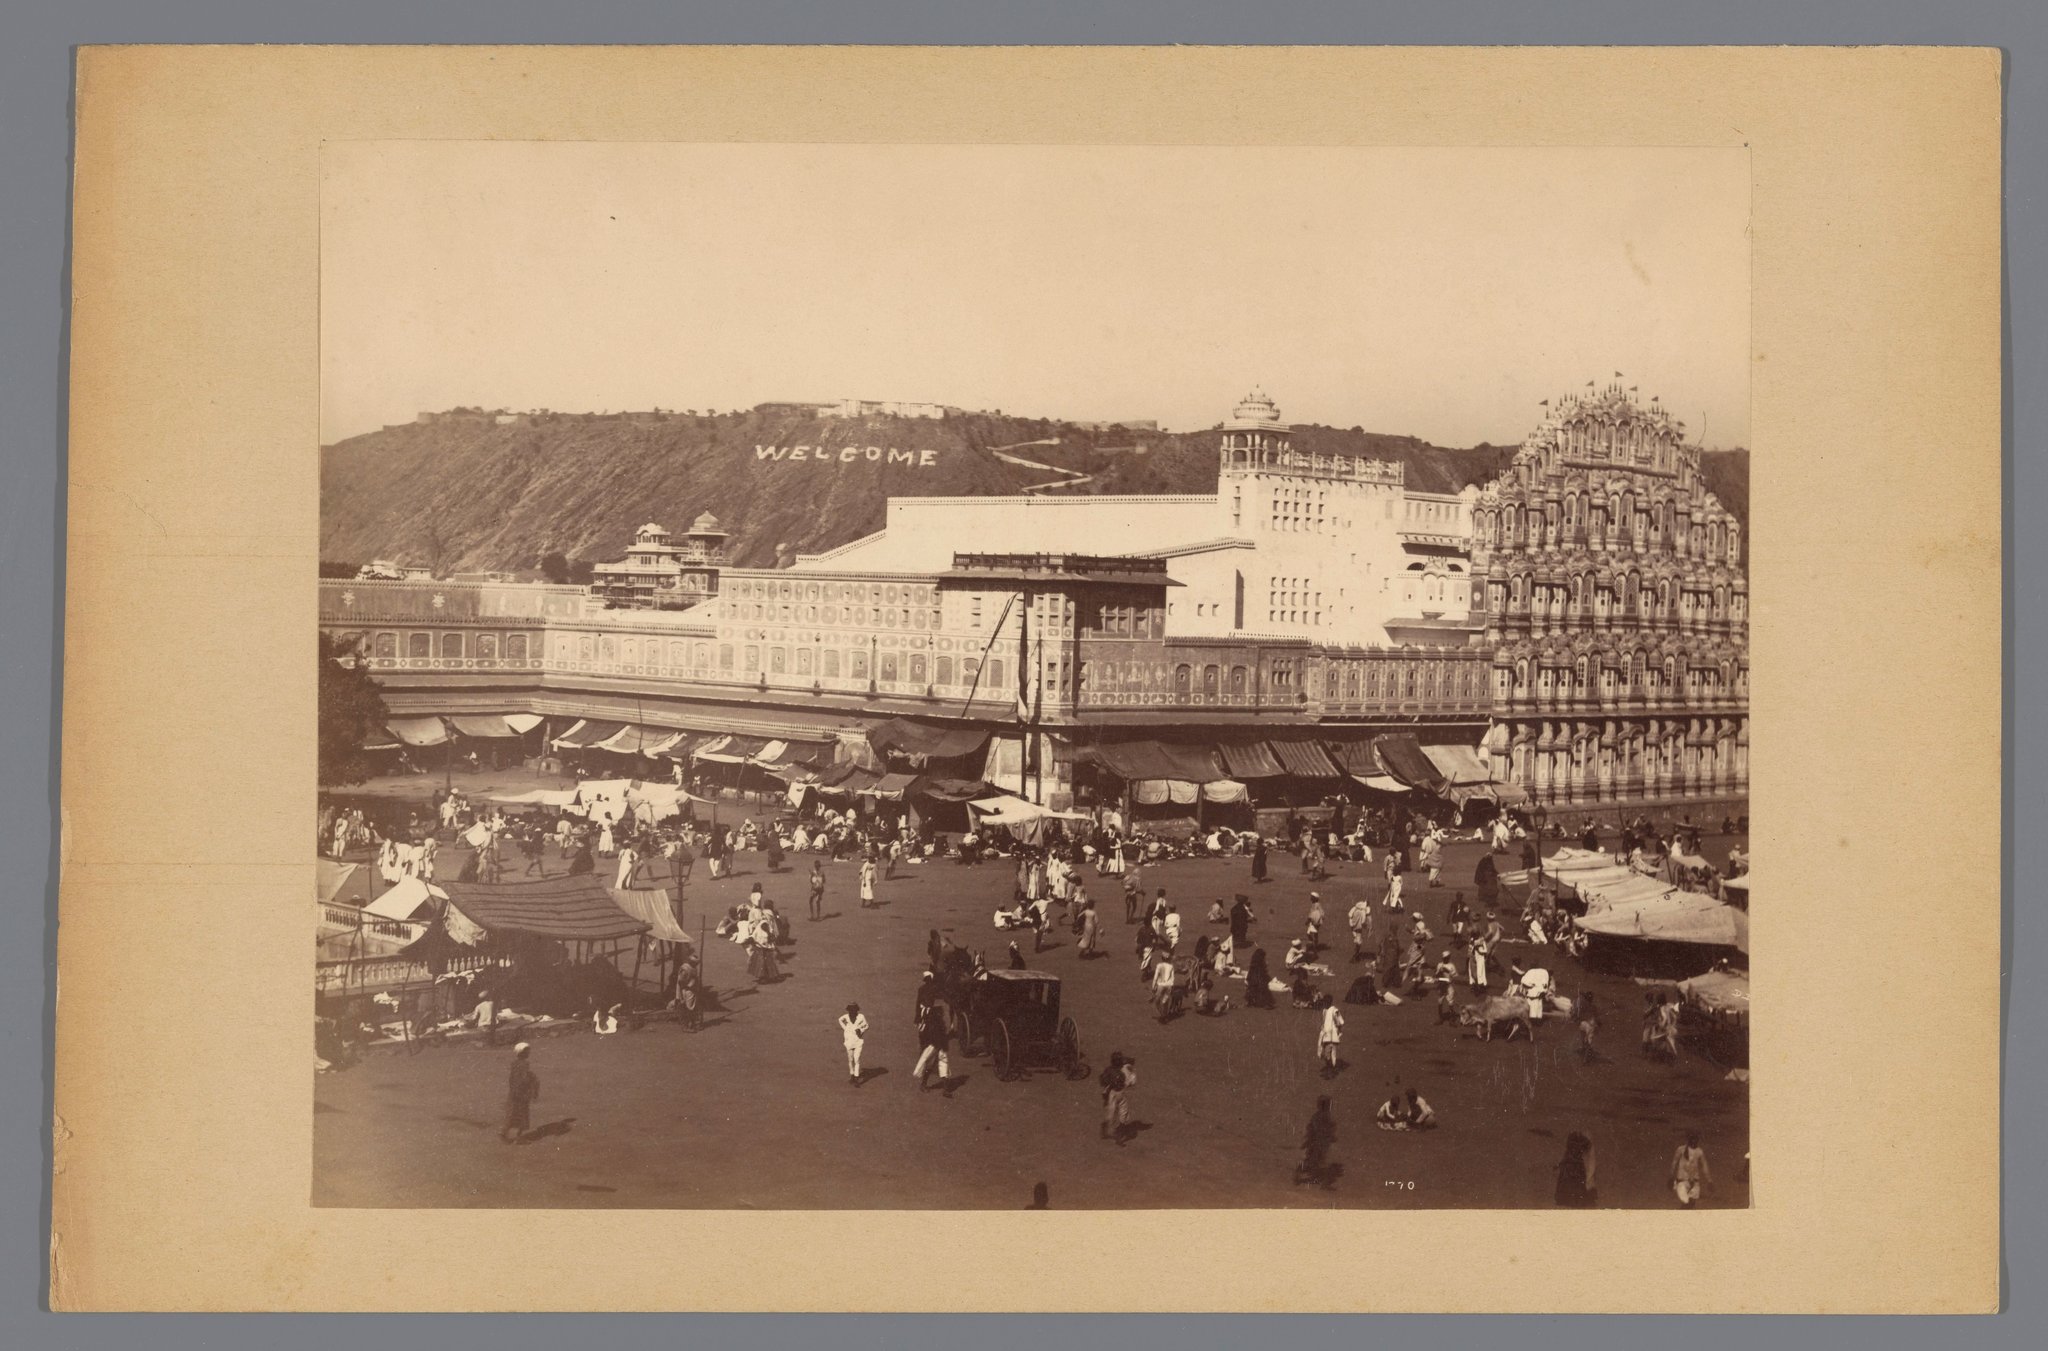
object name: photograph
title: View of the Hawa Mahal and Tripolia Bazaar in Jaipur, Rajasthan, India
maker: Anonymous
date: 1865-1890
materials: cardboard, paper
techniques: albumen print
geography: jaipur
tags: palace, market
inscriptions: inscription: ‘Jeypore/ Panorama Manuels chowk paiboor.’, number: ‘1770’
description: Het woord 'Welcome' was in gigantische letters aangebracht op een heuvel rond de stad ter gelegenheid van het bezoek van Edward, prins van Wales, in 1875-1876. Het is op de foto goed te zien.